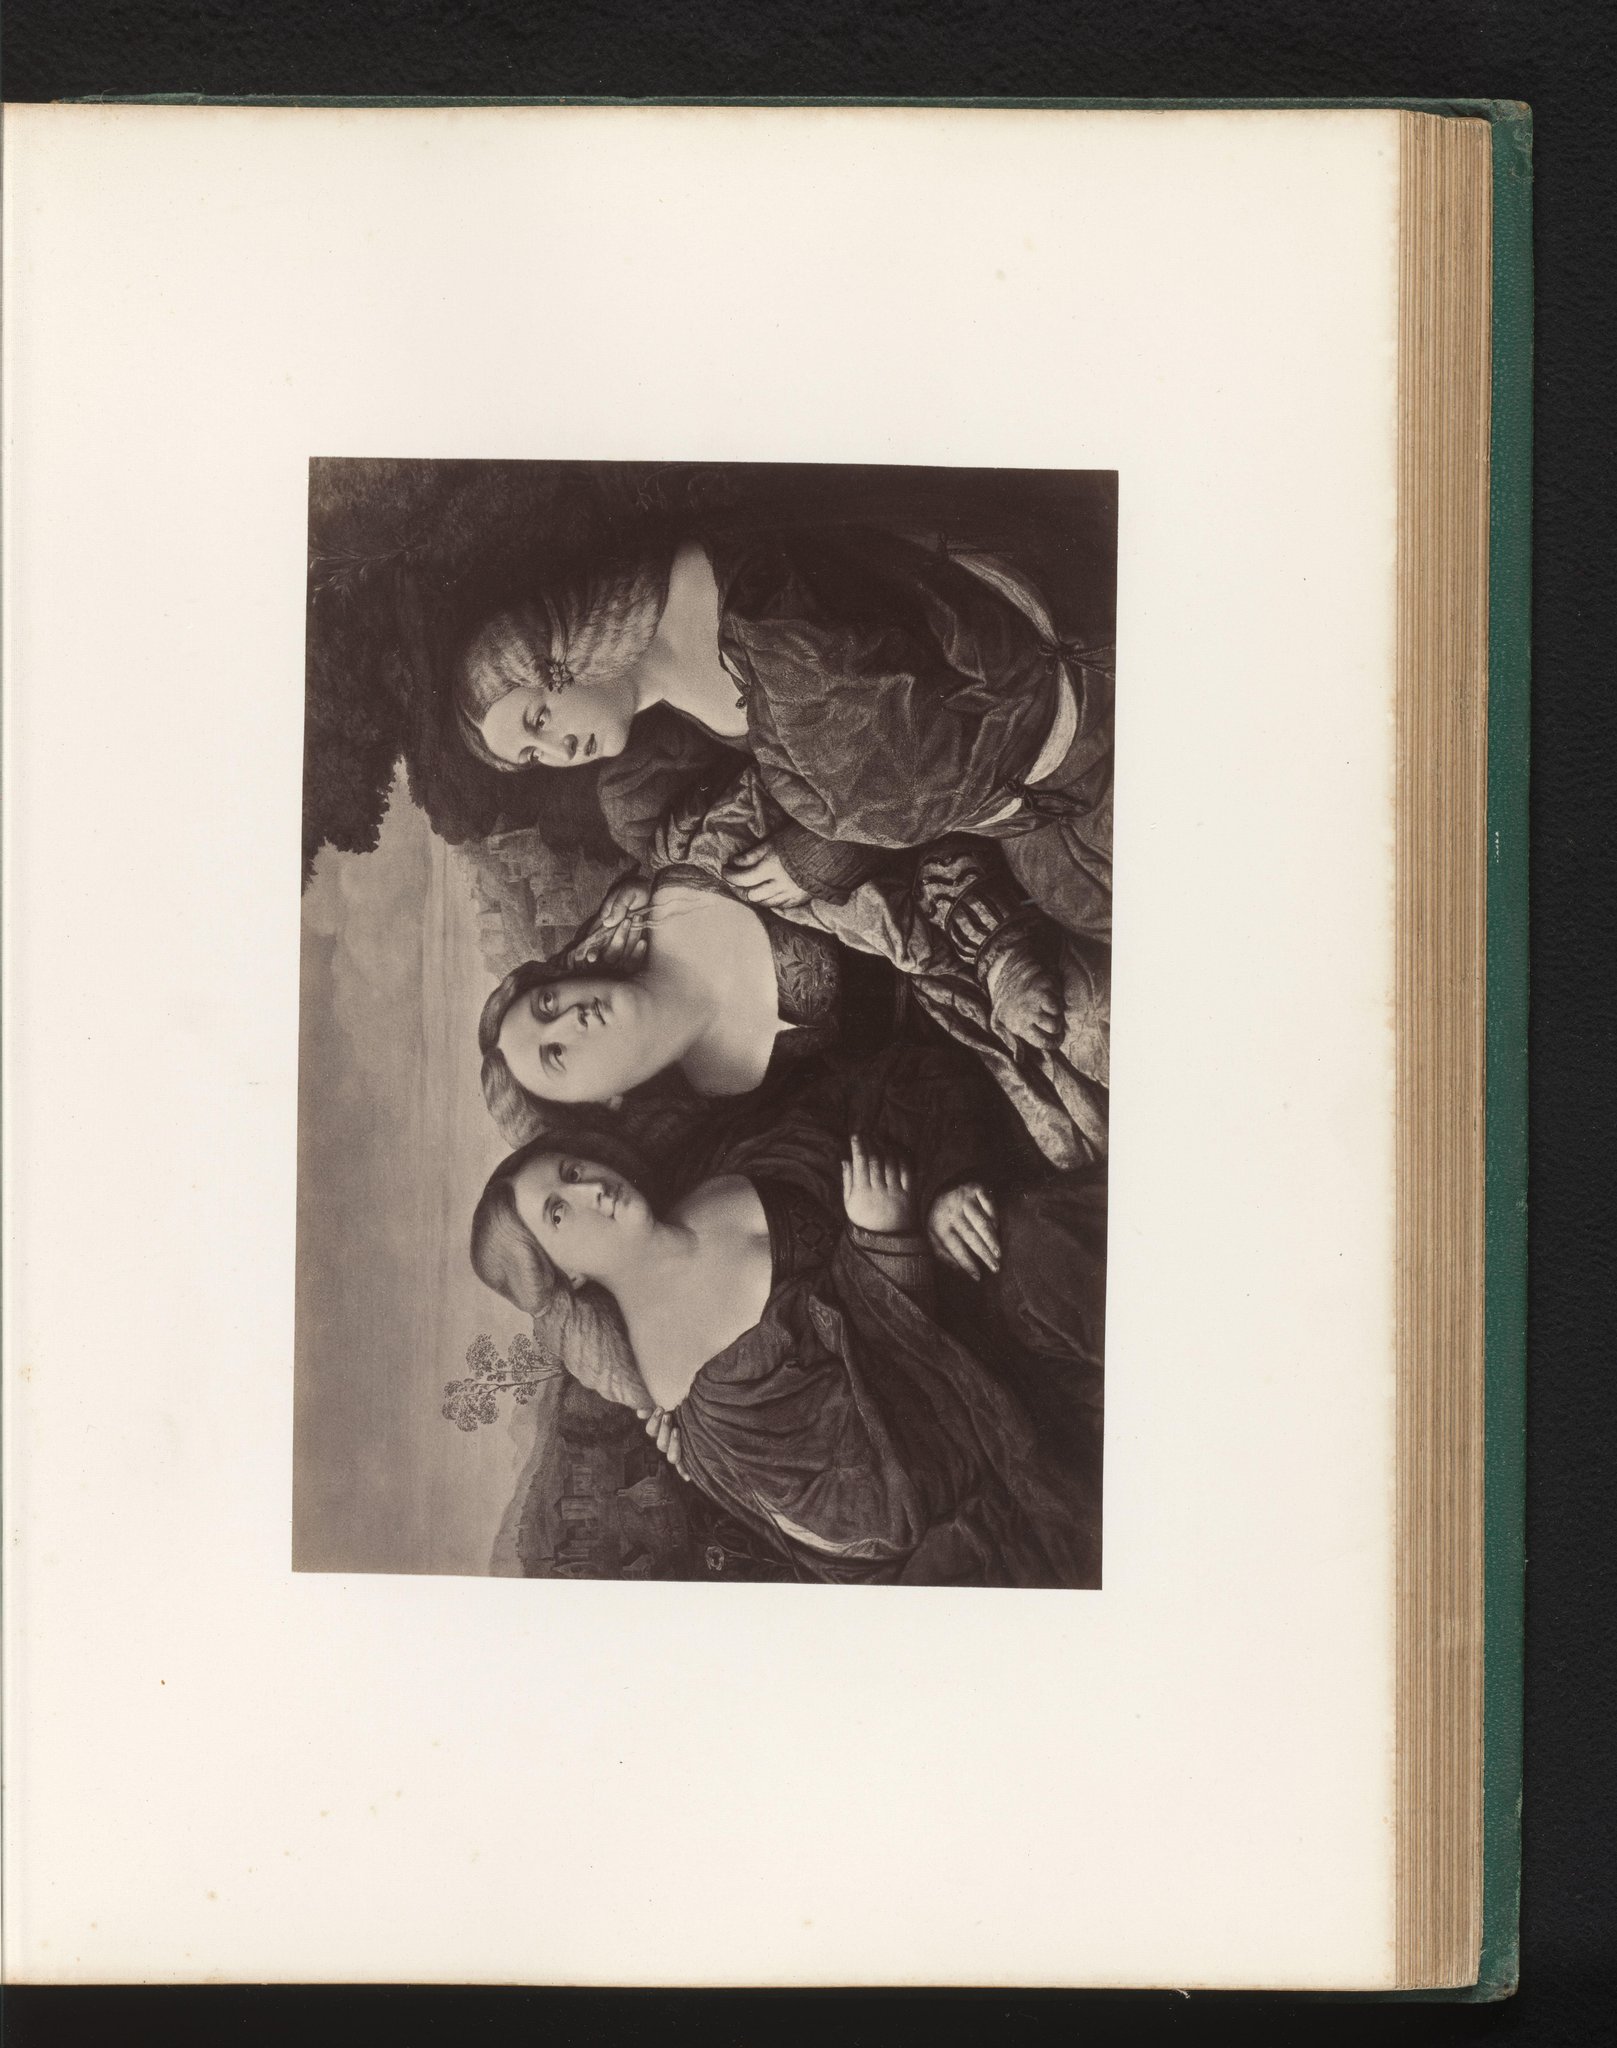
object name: reproduction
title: Palma Vecchio: Die drei Schwestern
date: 1870-1875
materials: paper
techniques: albumen print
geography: berlin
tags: sisters (second degree family relationships)